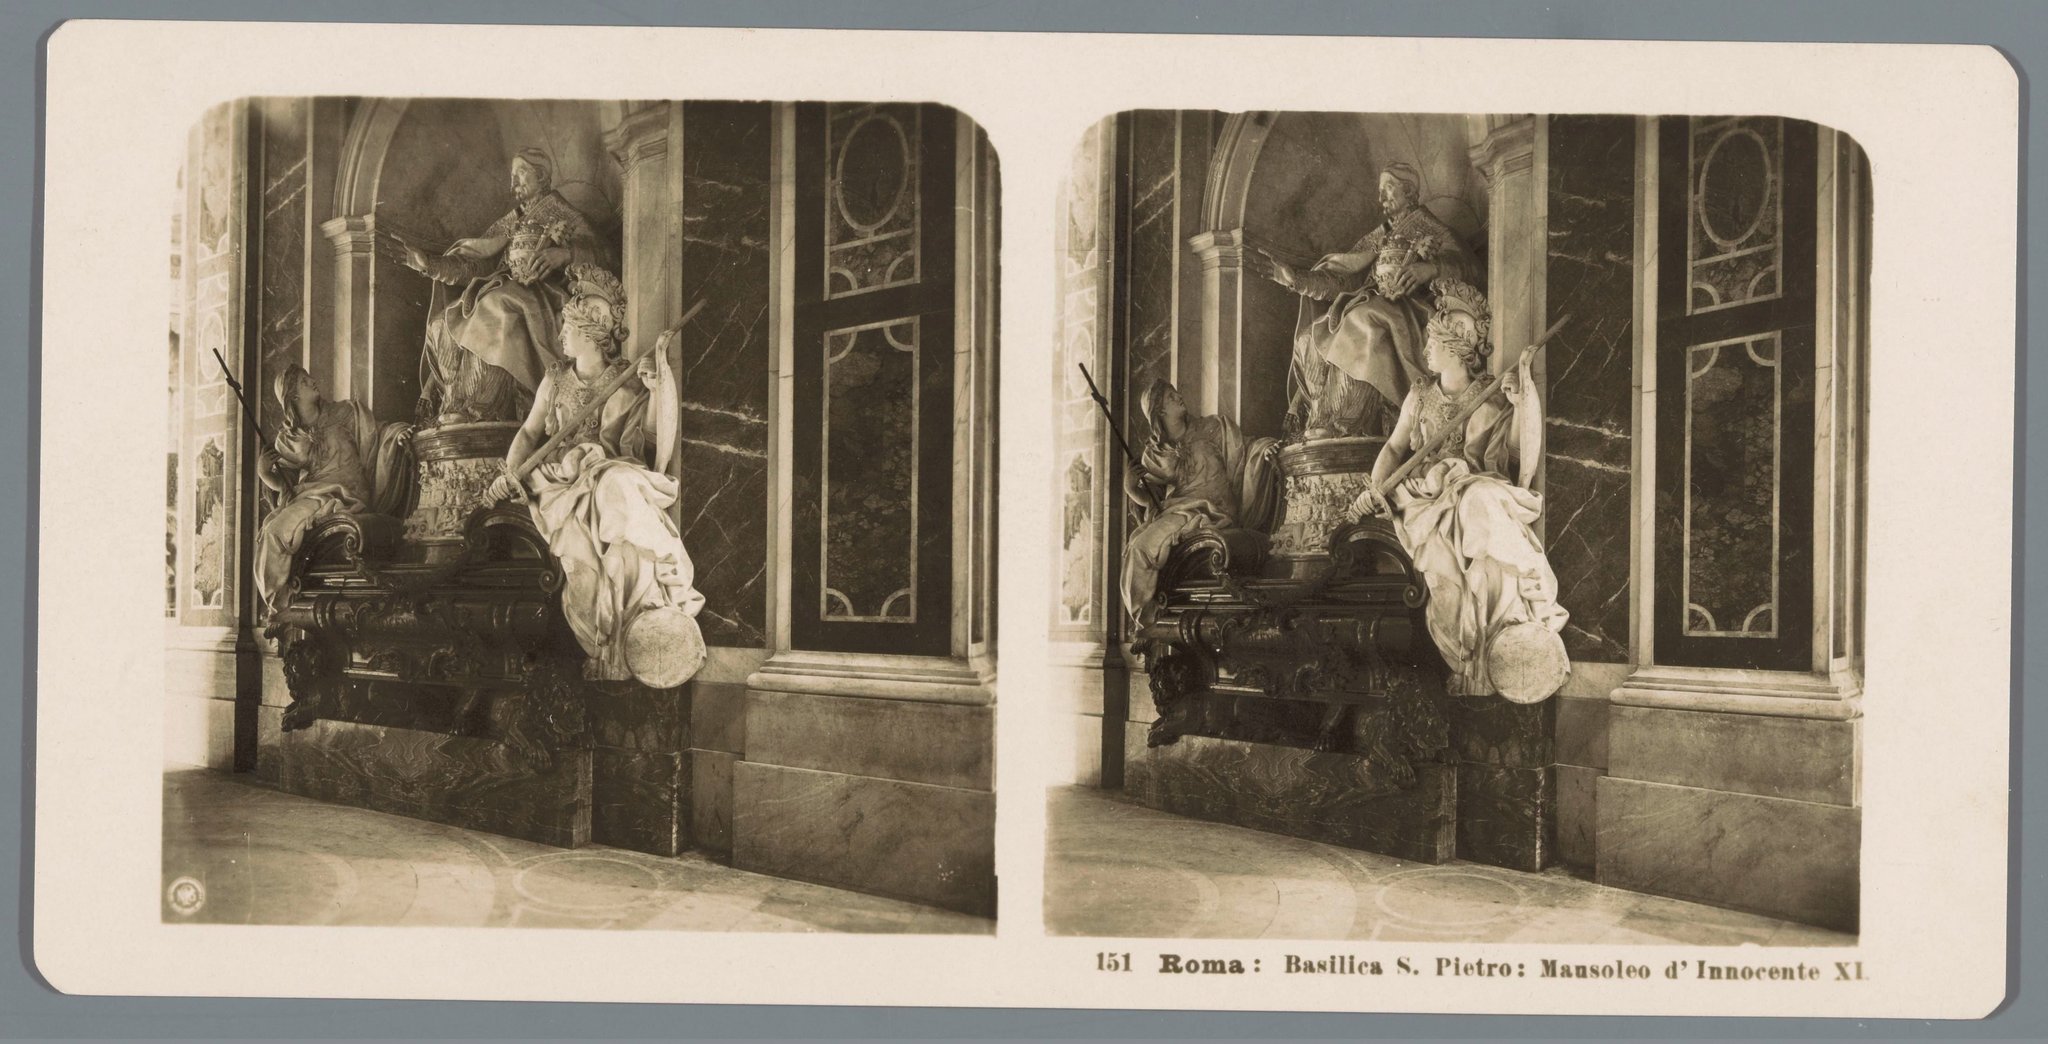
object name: stereograph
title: Graf van paus Innocentius XI in de Sint-Pietersbasiliek te Vaticaanstad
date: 1900-1910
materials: cardboard, photographic support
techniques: gelatin silver print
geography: sint-pietersbasiliek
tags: grave, tomb, interior of church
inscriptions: inscription: ‘NPG’, number: ‘151.’